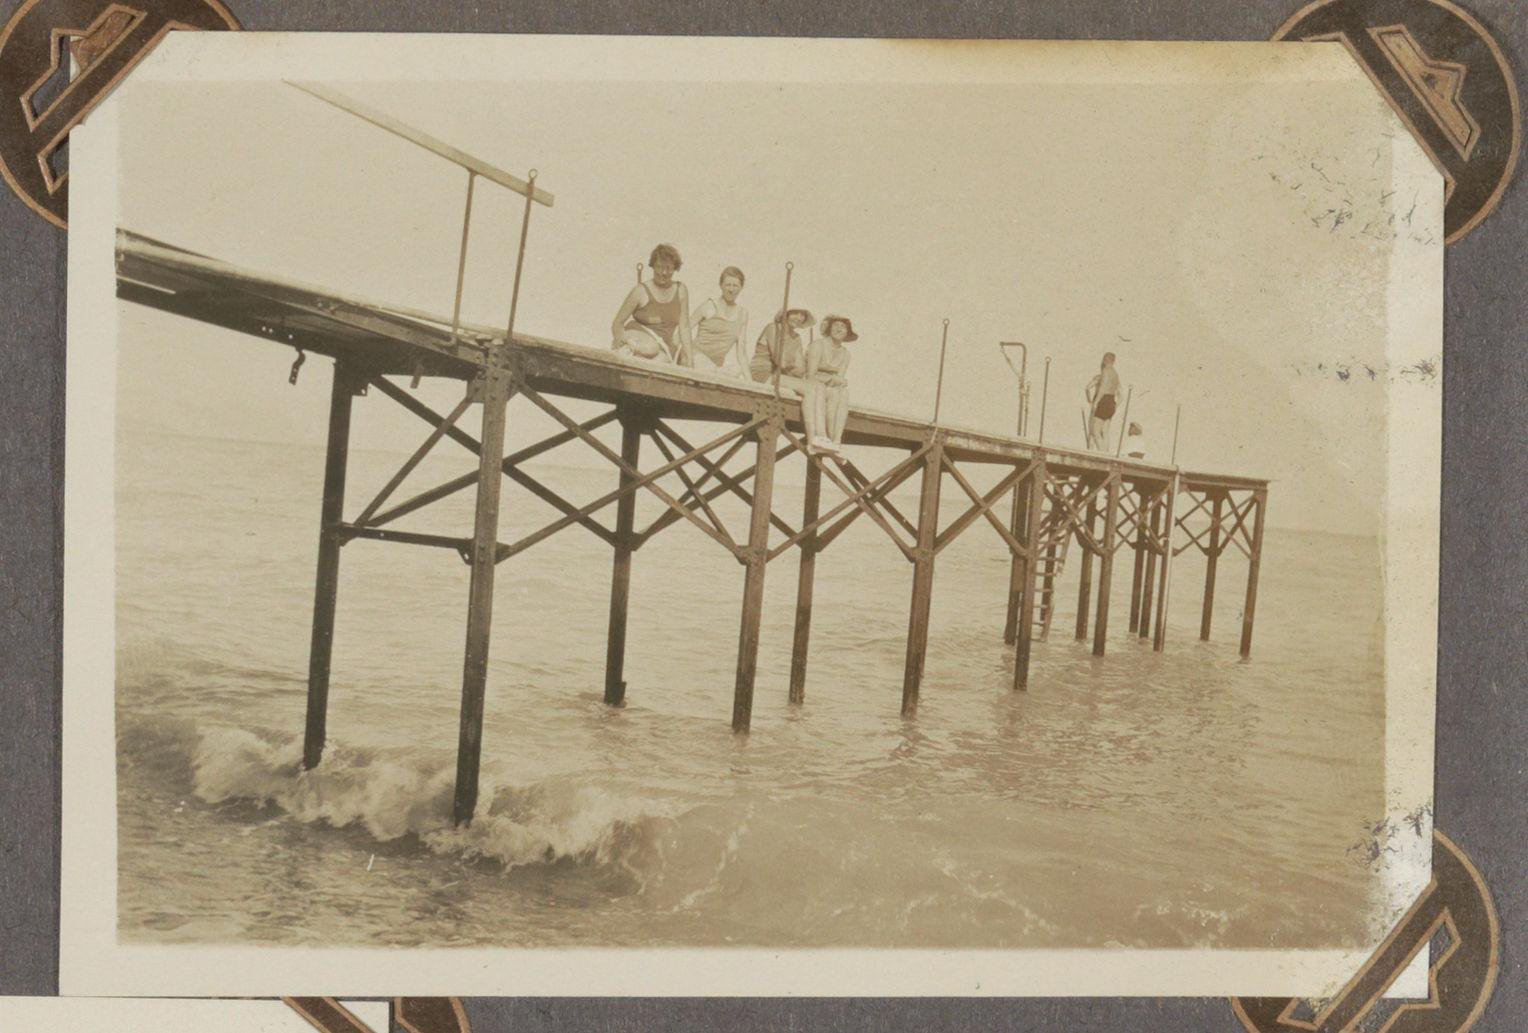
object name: photograph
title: Gezelschap zittend op een pier aan een strand, vermoedelijk in Zuid-Frankrijk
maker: Anonymous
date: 1931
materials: photographic support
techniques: gelatin silver print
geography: southern france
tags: adult woman, adult man, pier, quay, wharf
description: Onderdeel van Fotoalbum met opnames van vakanties in Zuid-Frankrijk.